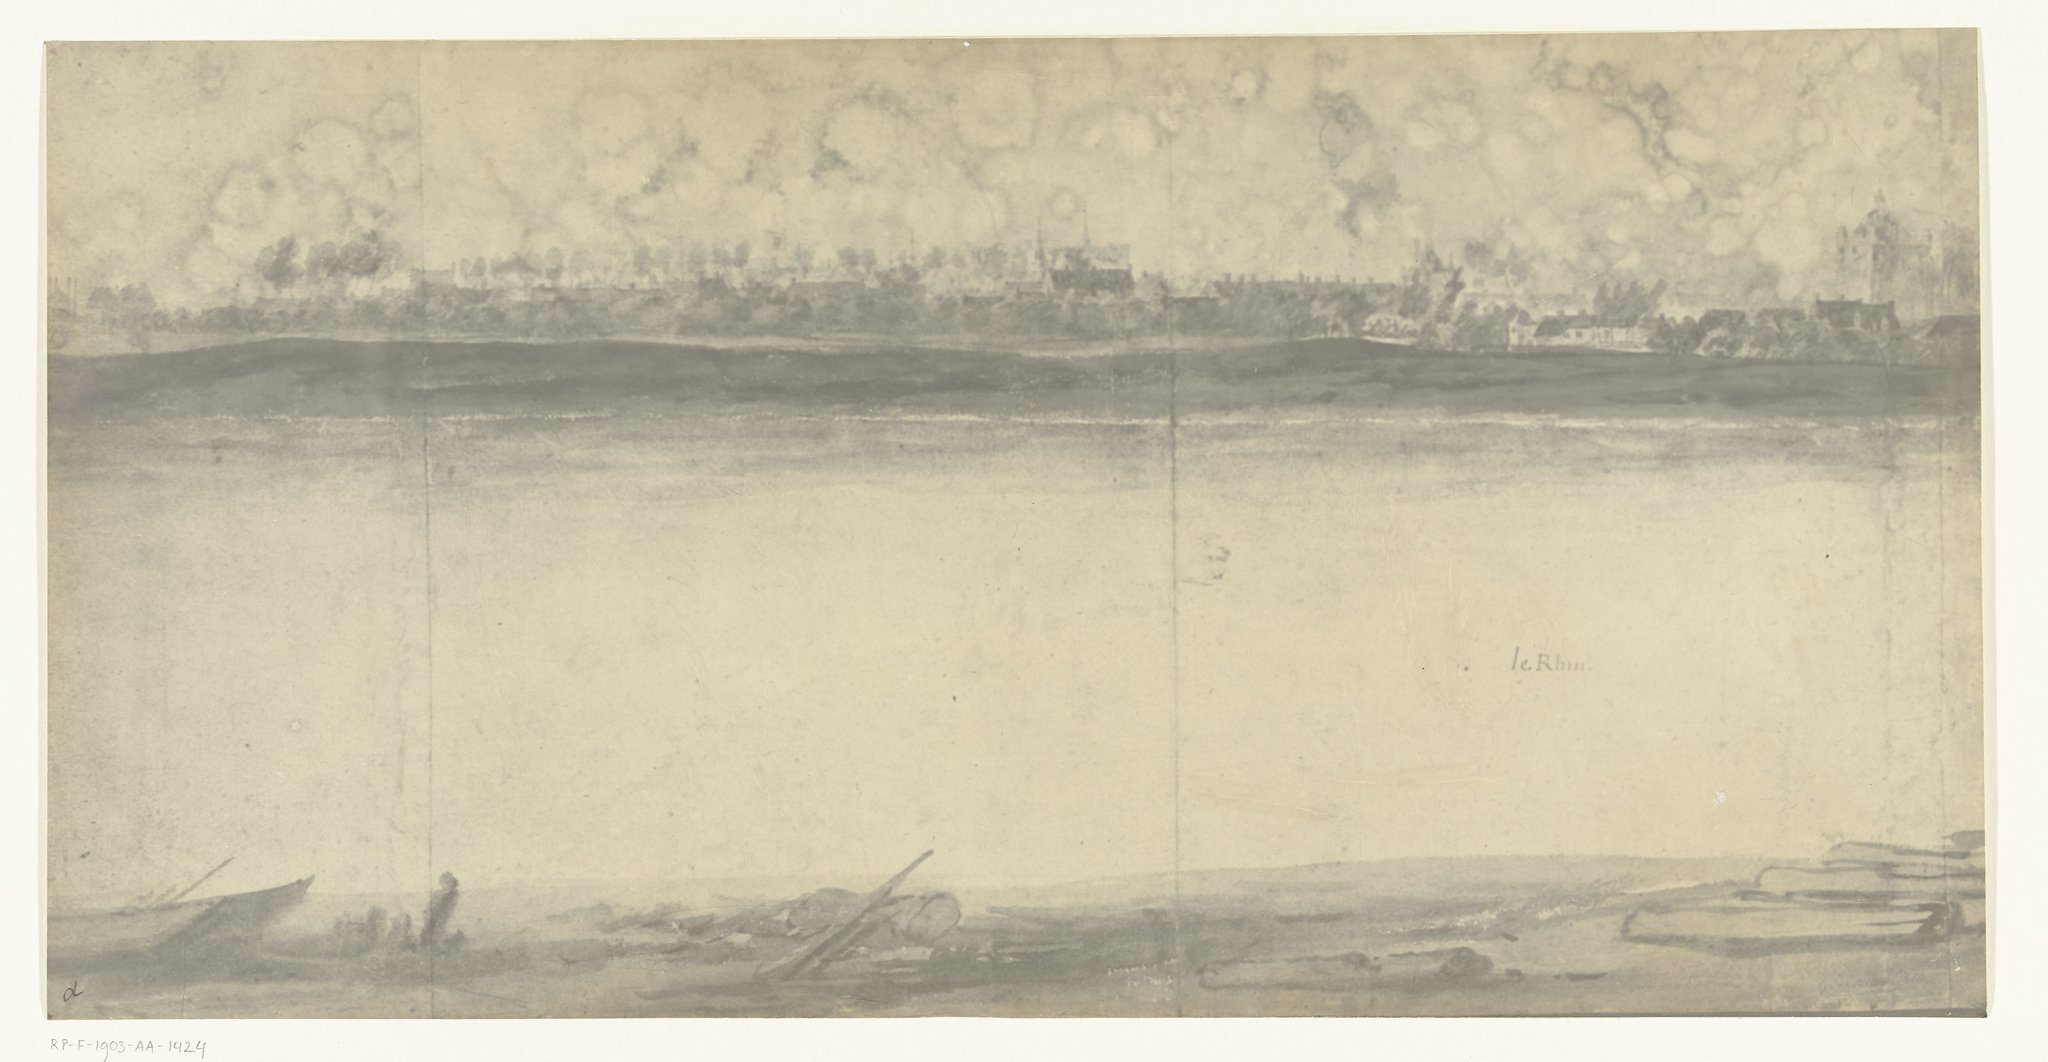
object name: photograph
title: Foto's van tekeningen van de Franse inval in de Nederlanden in 1672 door Adam Frans van der Meulen bewaard in de Manufacture des Gobelins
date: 1900-1903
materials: paper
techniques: gelatin silver print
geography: france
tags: lodewijk xiv (koning van frankrijk), city-view, and landscape with man-made constructions, rampjaar (disaster year)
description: Niet in Frederik Muller; door het RPK toegevoegd nummer. Onderdeel van een groep van ca. 50 foto's van tekeningen van de Franse inval in de Nederlanden in 1672 door Adam Frans van der Meulen, bewaard in de Manufacture Nationale des Gobelins te Parijs.